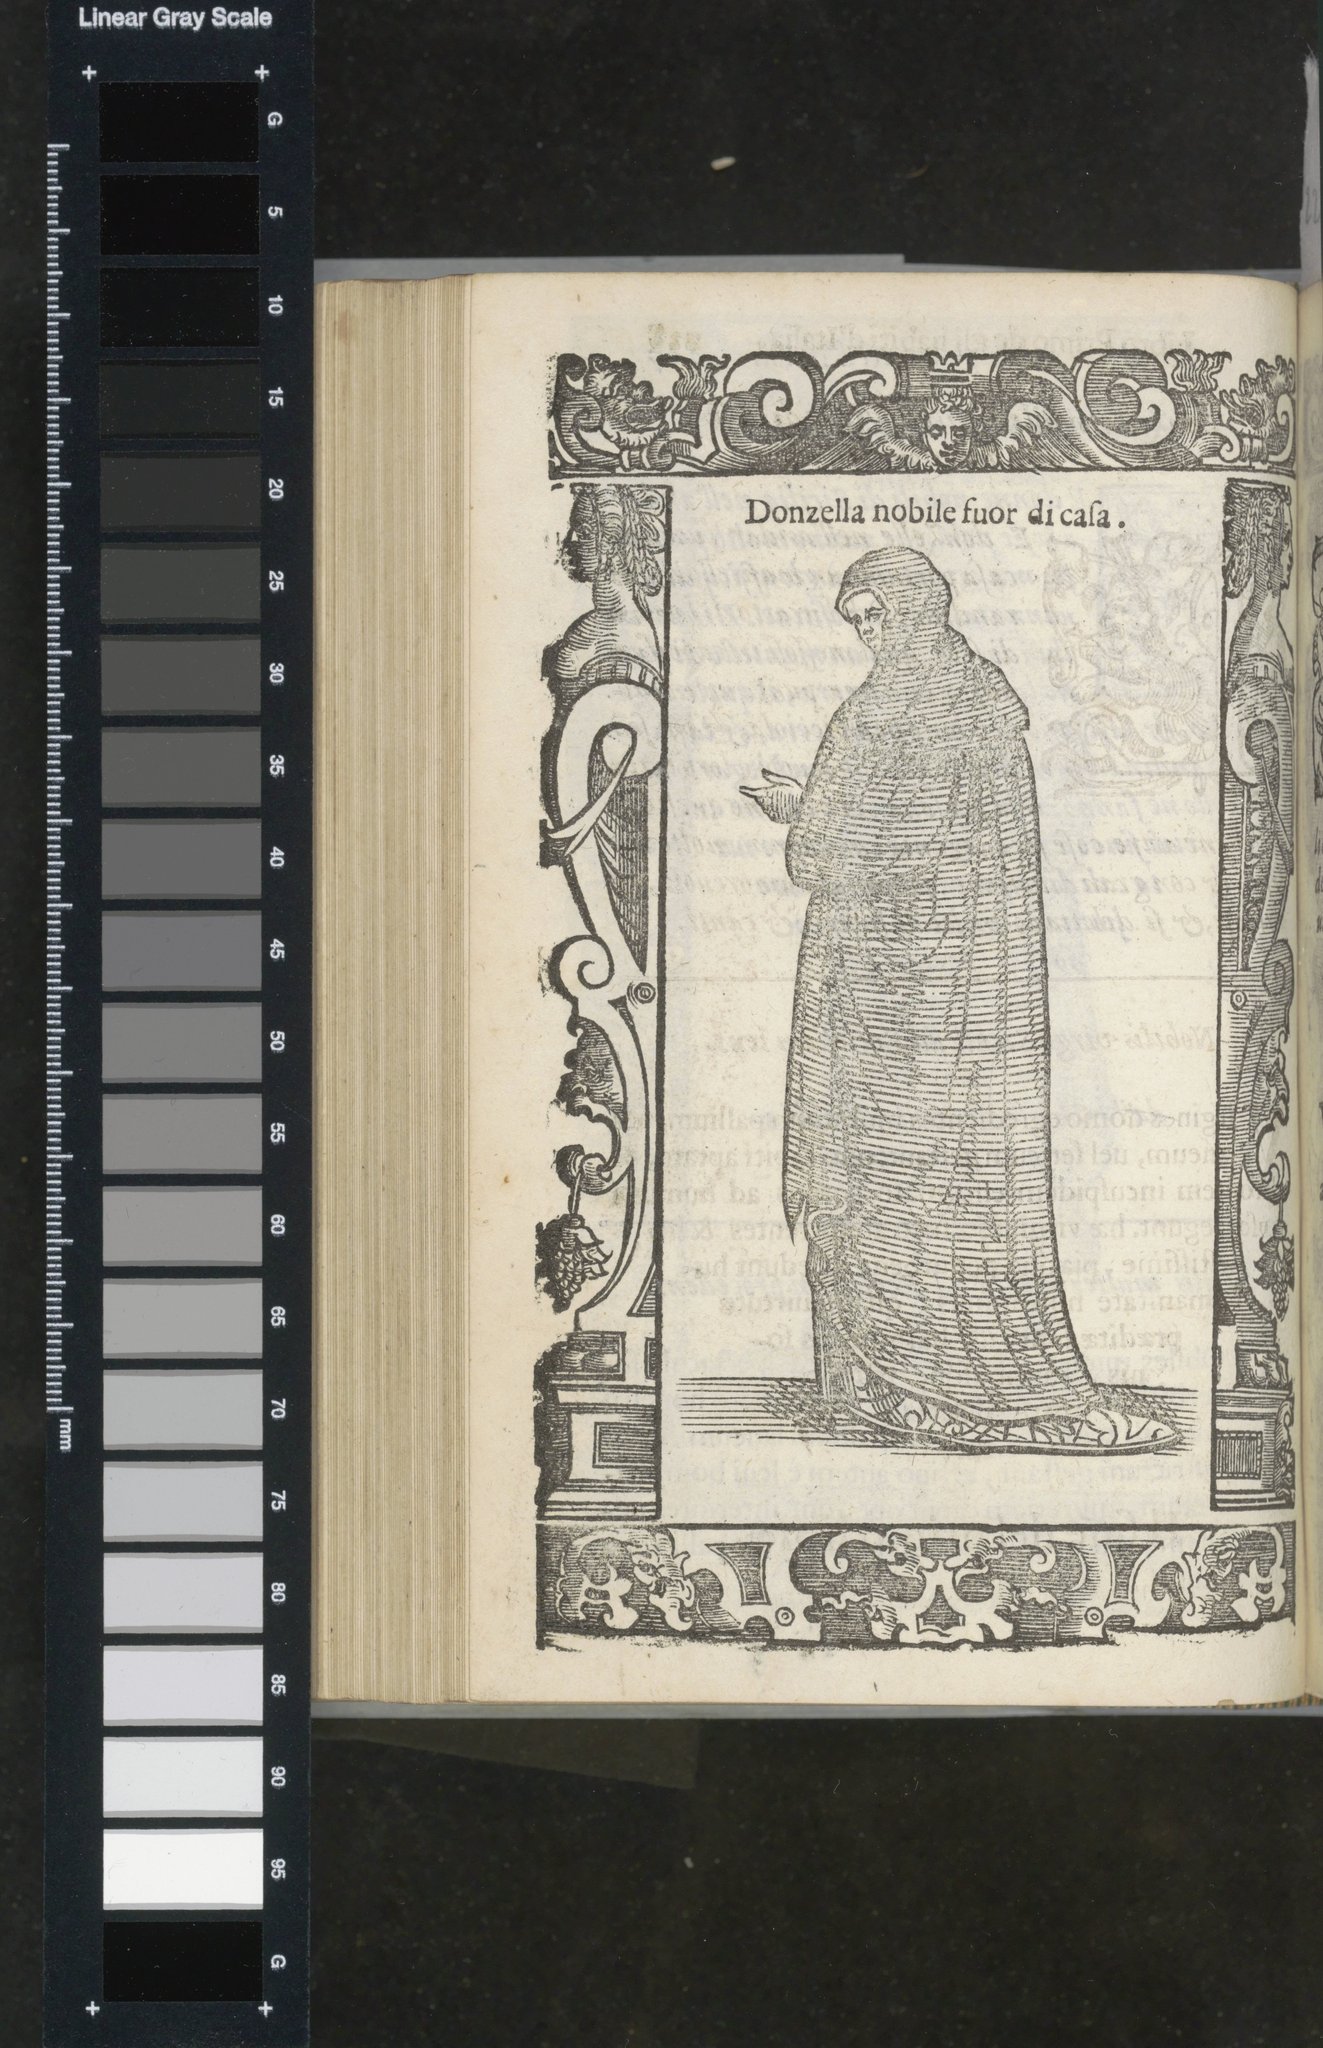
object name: costume print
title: Donzella nobile fuor di casa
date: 1598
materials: paper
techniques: woodcut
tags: fashion plates